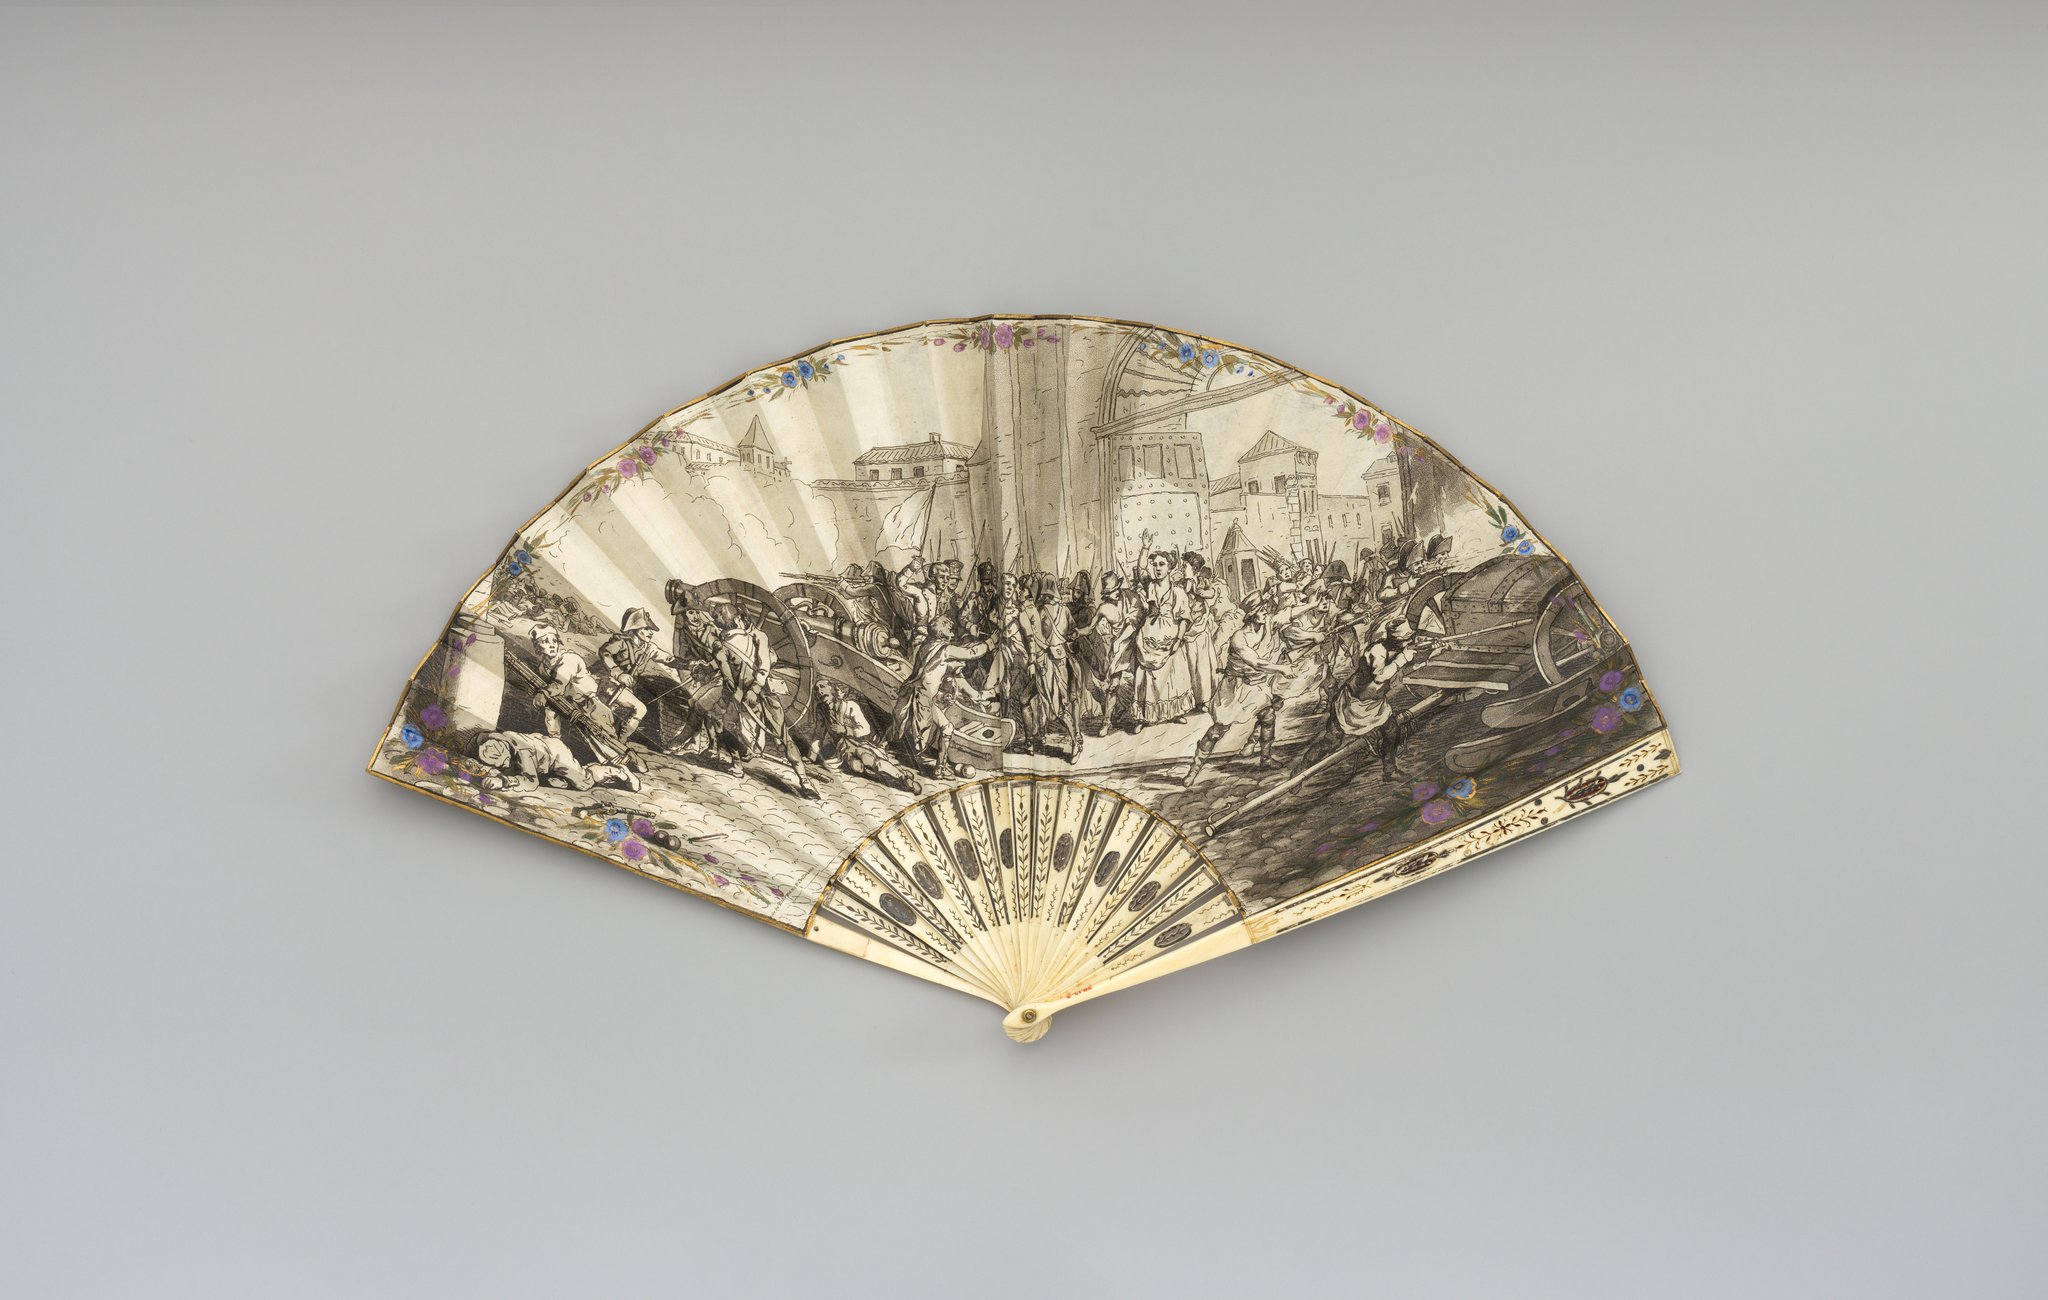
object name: fan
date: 1813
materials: ivory, paper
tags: cannons,men,women